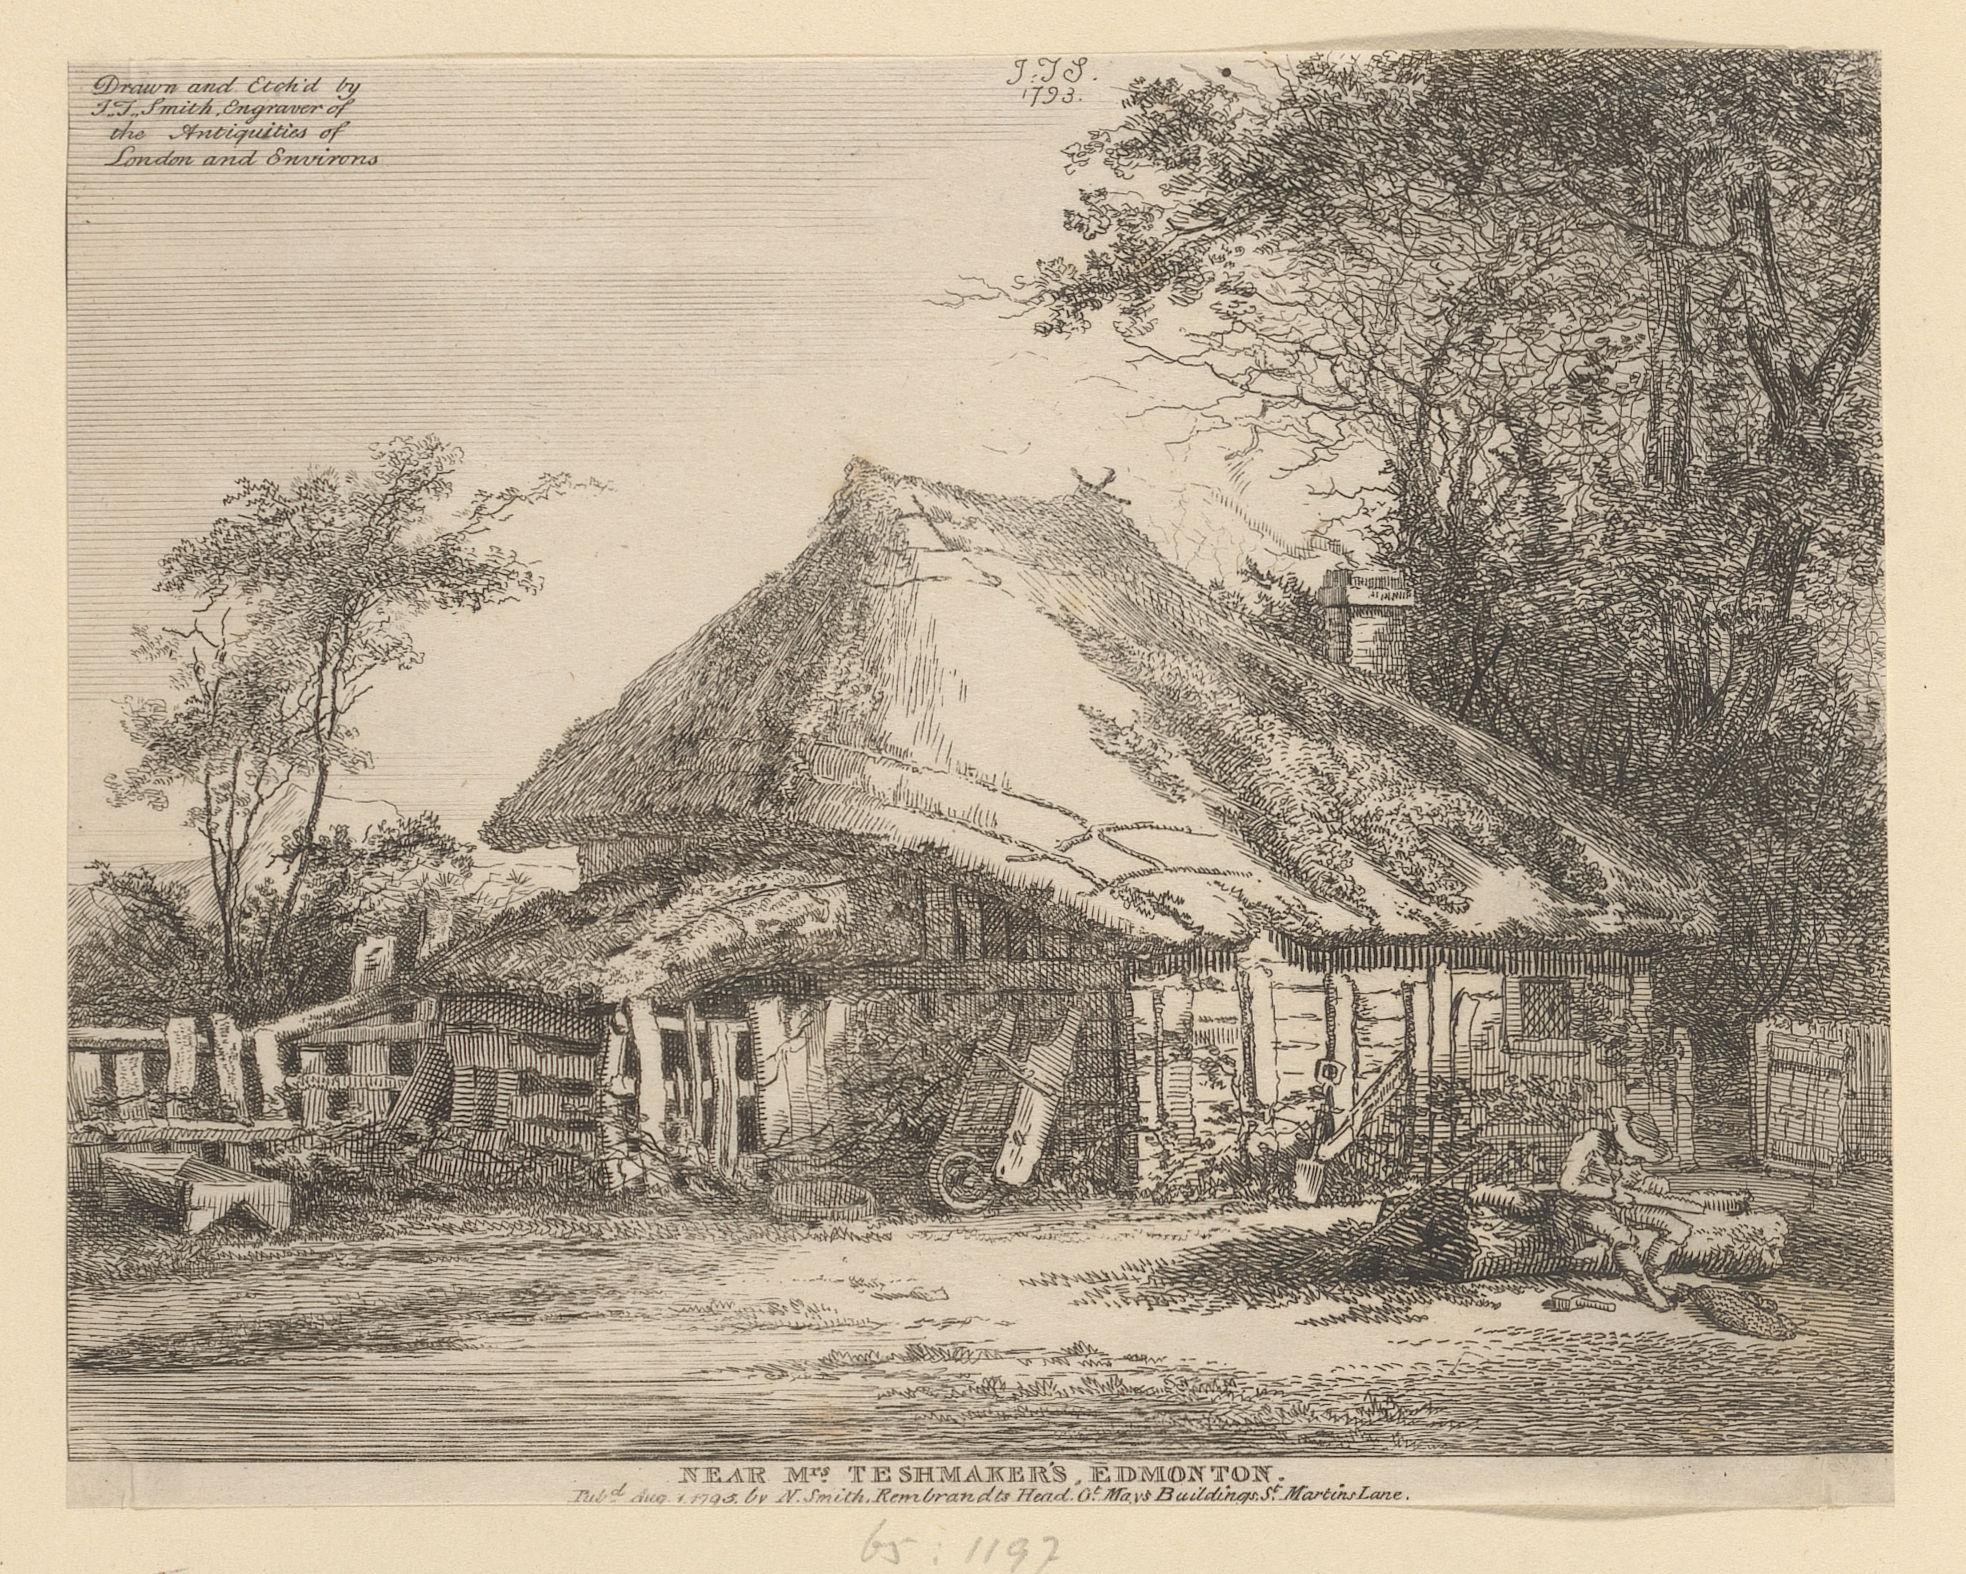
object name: album leaf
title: Near Mrs. Teshmaker's Edmonton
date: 1793-1795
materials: paper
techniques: etching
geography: london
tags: landscapes (+ landscape with figures, staffage), farm (building)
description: Deze prent hoort bij een serie van 20 prenten. Prent maakt mogelijk deel uit van een serie van 200 prenten. Deze serie is onder de titel 'A Collection of two hundred original etchings' voor het eerst uitgegeven door J.M. Greery in 1816.